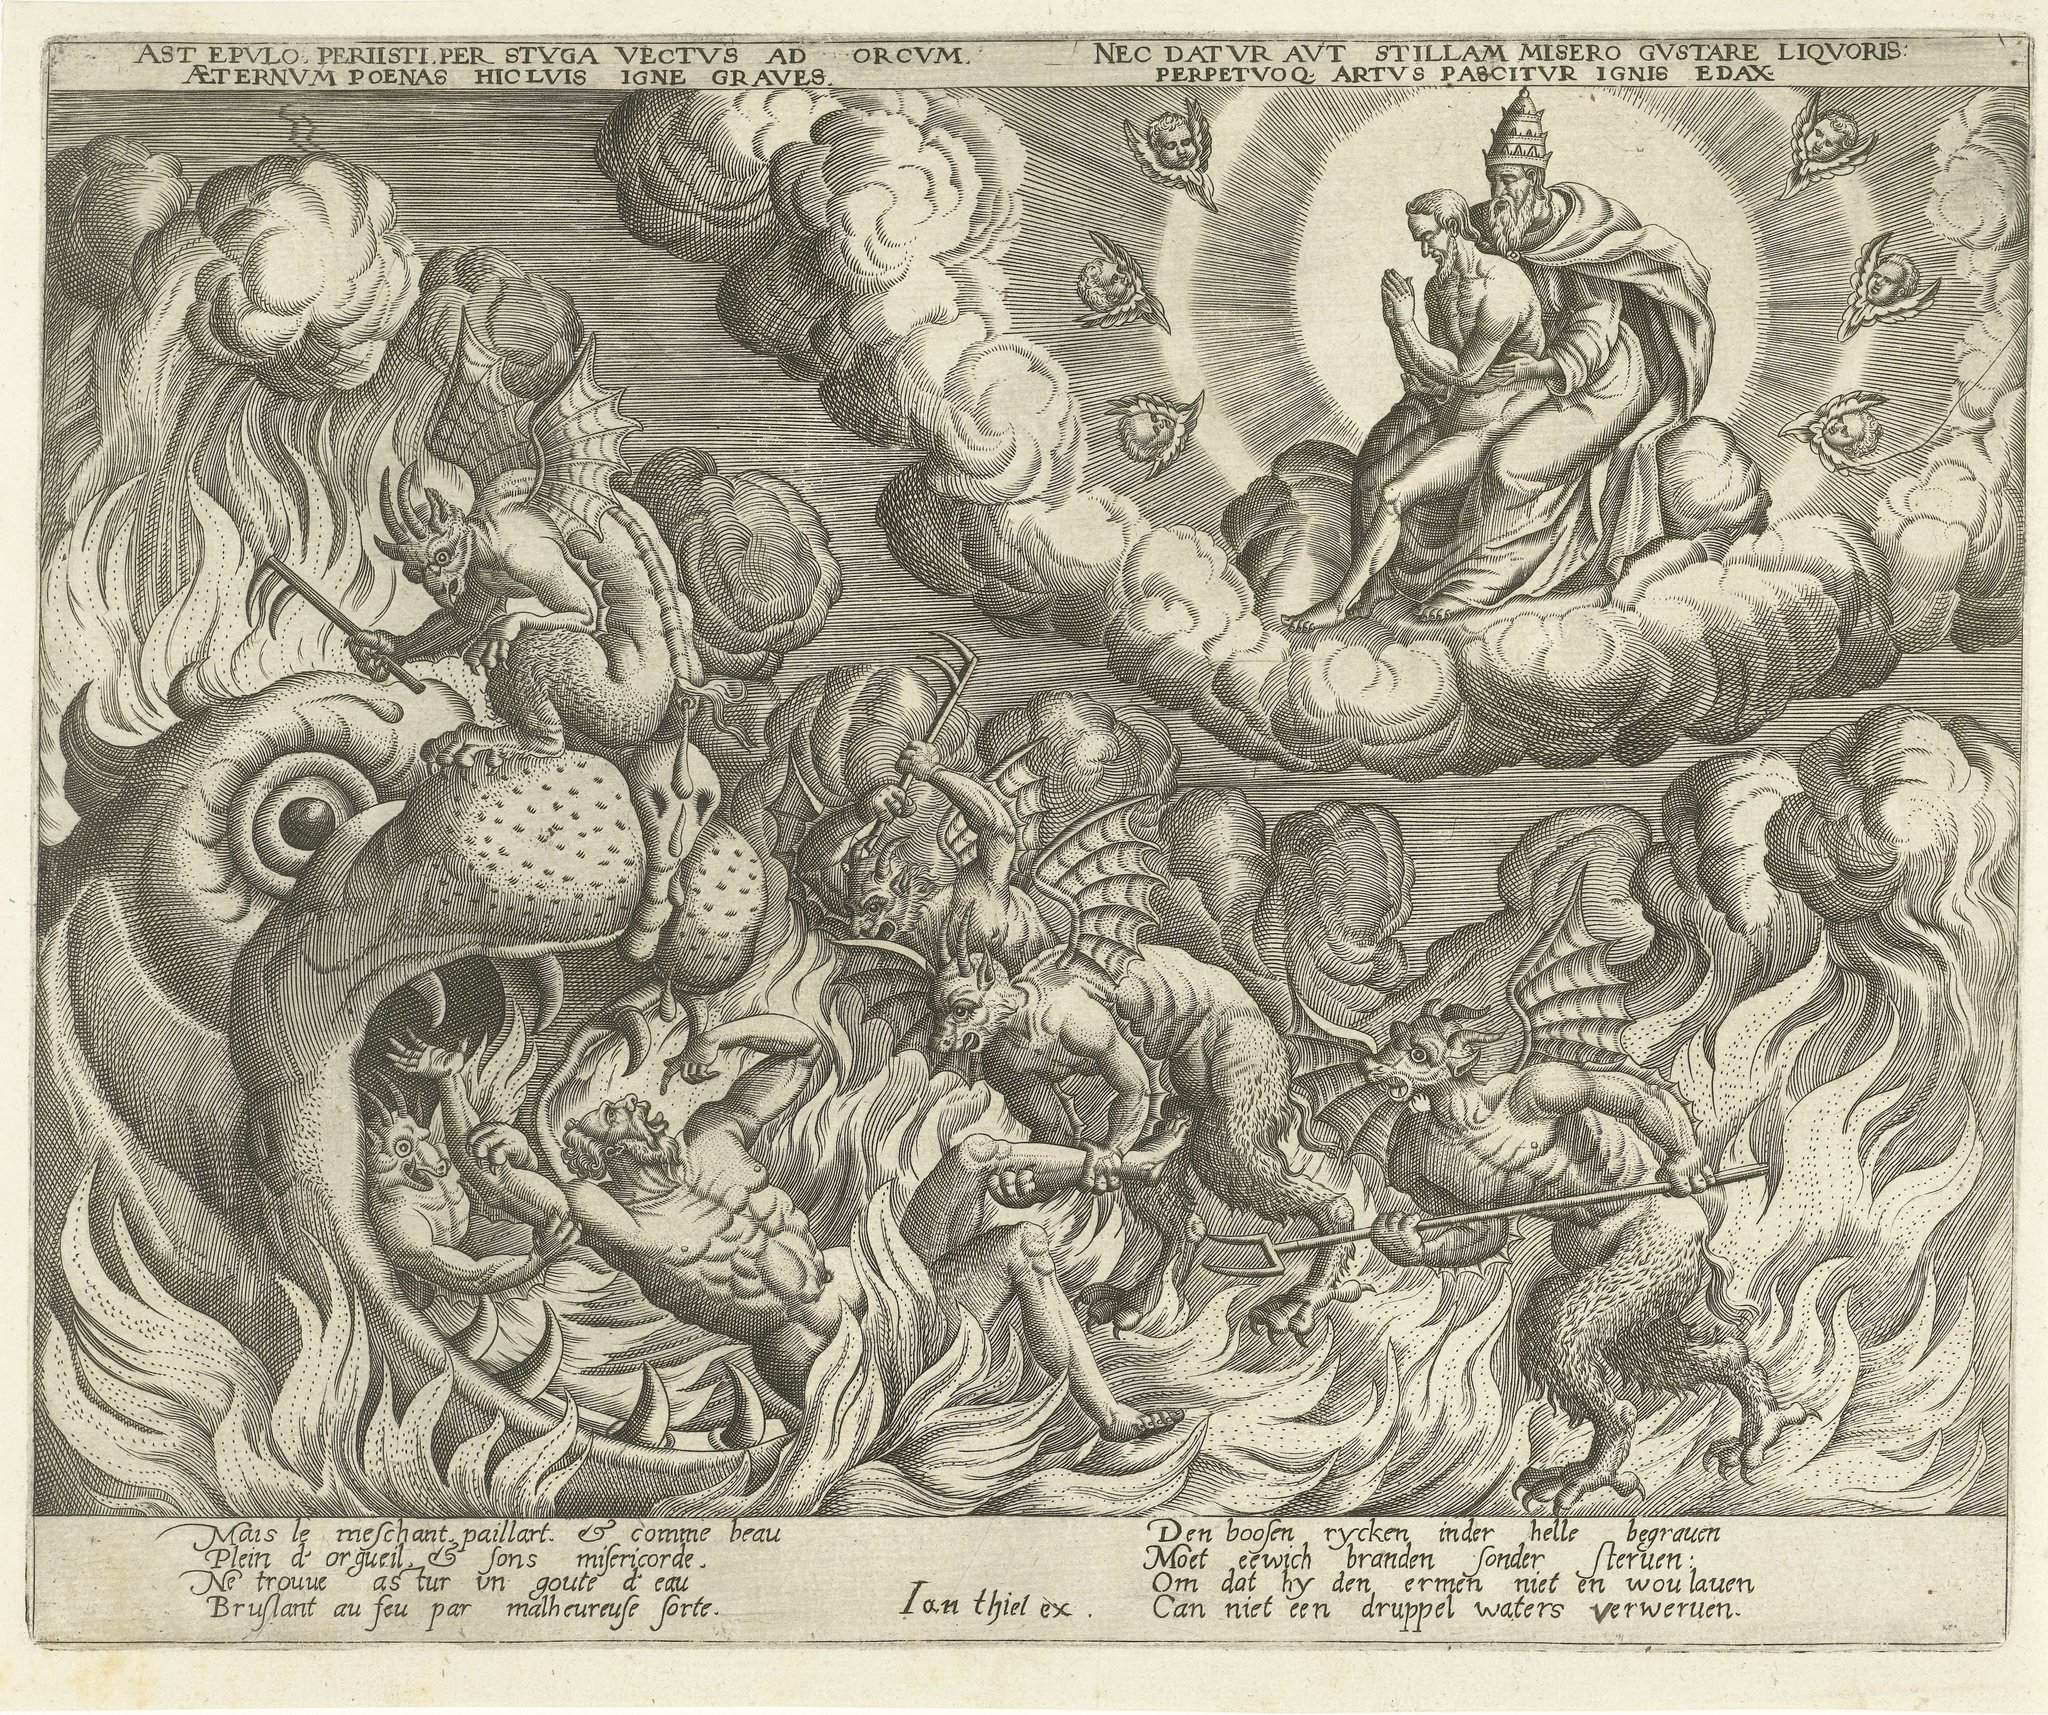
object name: print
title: Visioen van de rijke man in de hel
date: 1575-1599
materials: paper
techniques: engraving, etching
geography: antwerp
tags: in hell dives sees lazarus in paradise; usually dives pointing at his tongue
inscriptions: collector's mark: Lugt 2228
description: De rijke man valt in de muil van het hellebeest. In de hemel de arme Lazarus op de schoot van God de Vader. De prent heeft een Latijns opschrift en een Nederlands en Frans onderschrift. Hij maakt deel uit van een serie over gelijkenis van de rijke man en Lazarus.